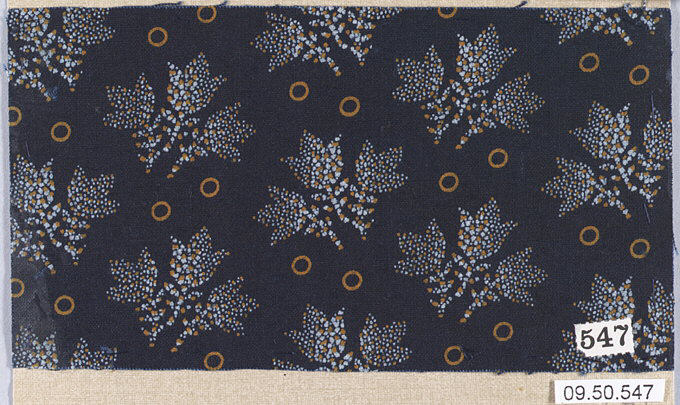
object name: piece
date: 1801-1900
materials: cotton